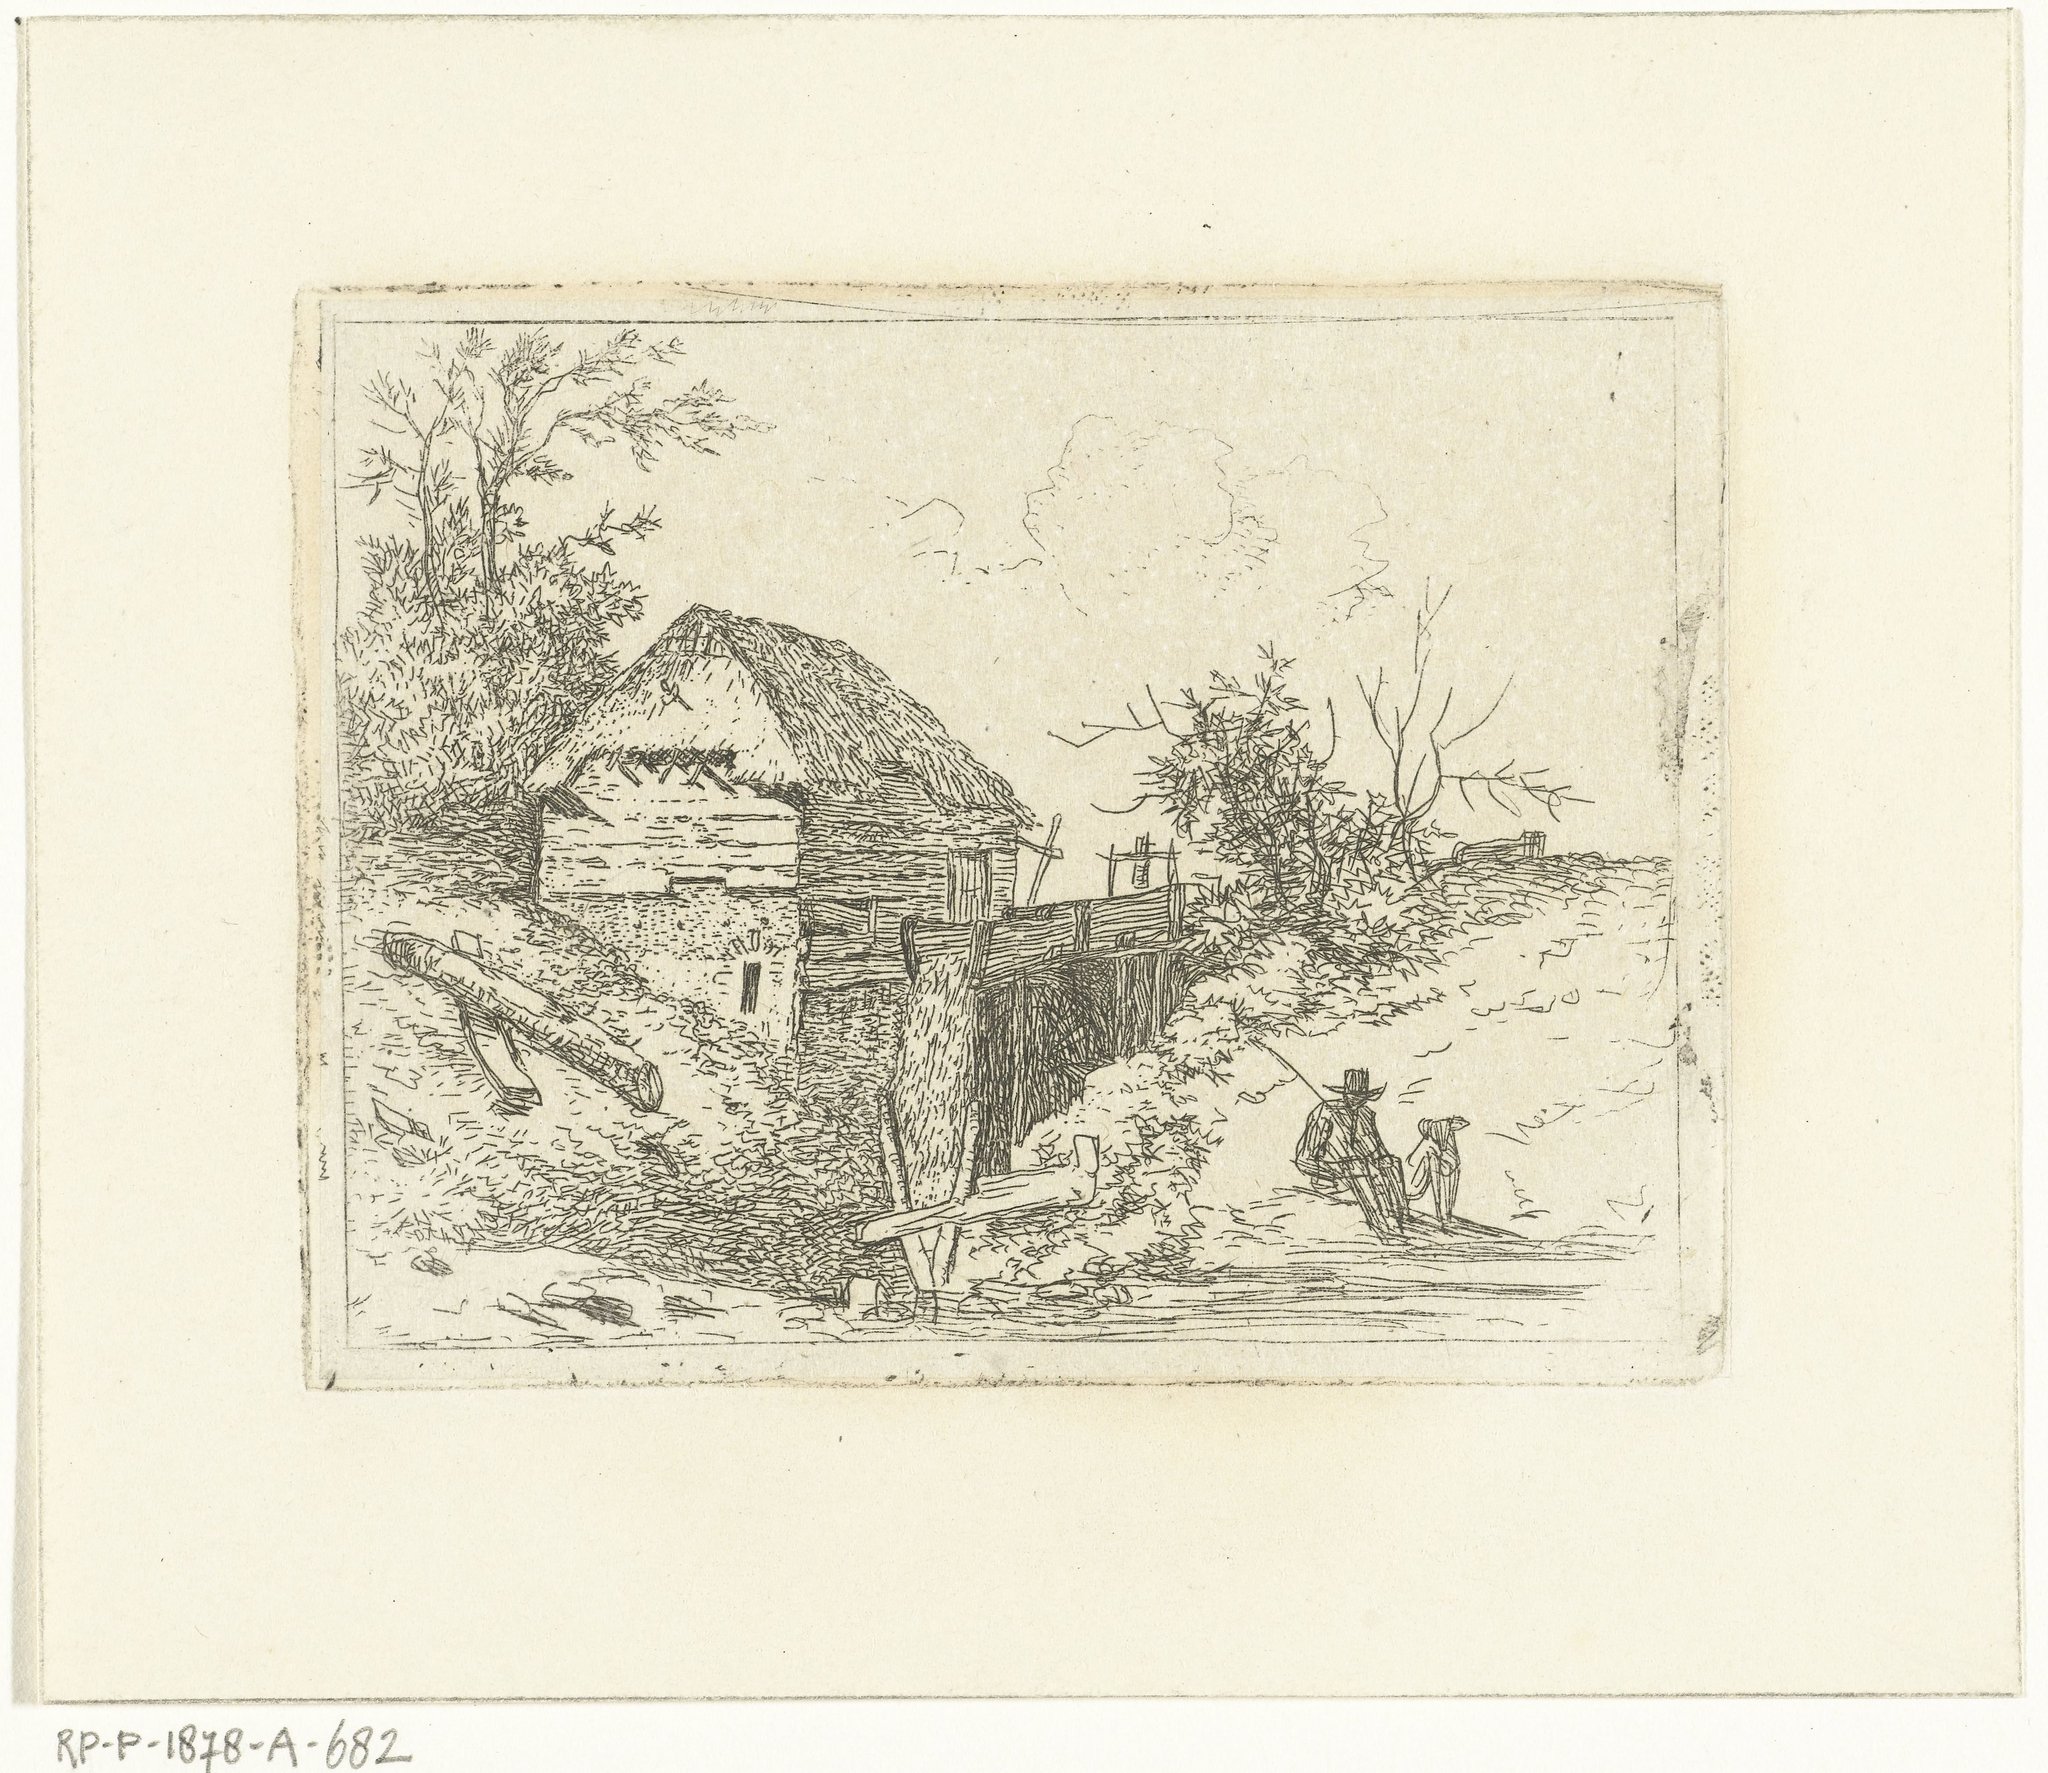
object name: print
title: Landschap met watermolen en man met hond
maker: albertus brondgeest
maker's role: draughtsman, print maker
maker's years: 1786-1849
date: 1796-1849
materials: paper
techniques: etching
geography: netherlands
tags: watermill, watermill in landscape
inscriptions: collector's mark: Lugt 2228